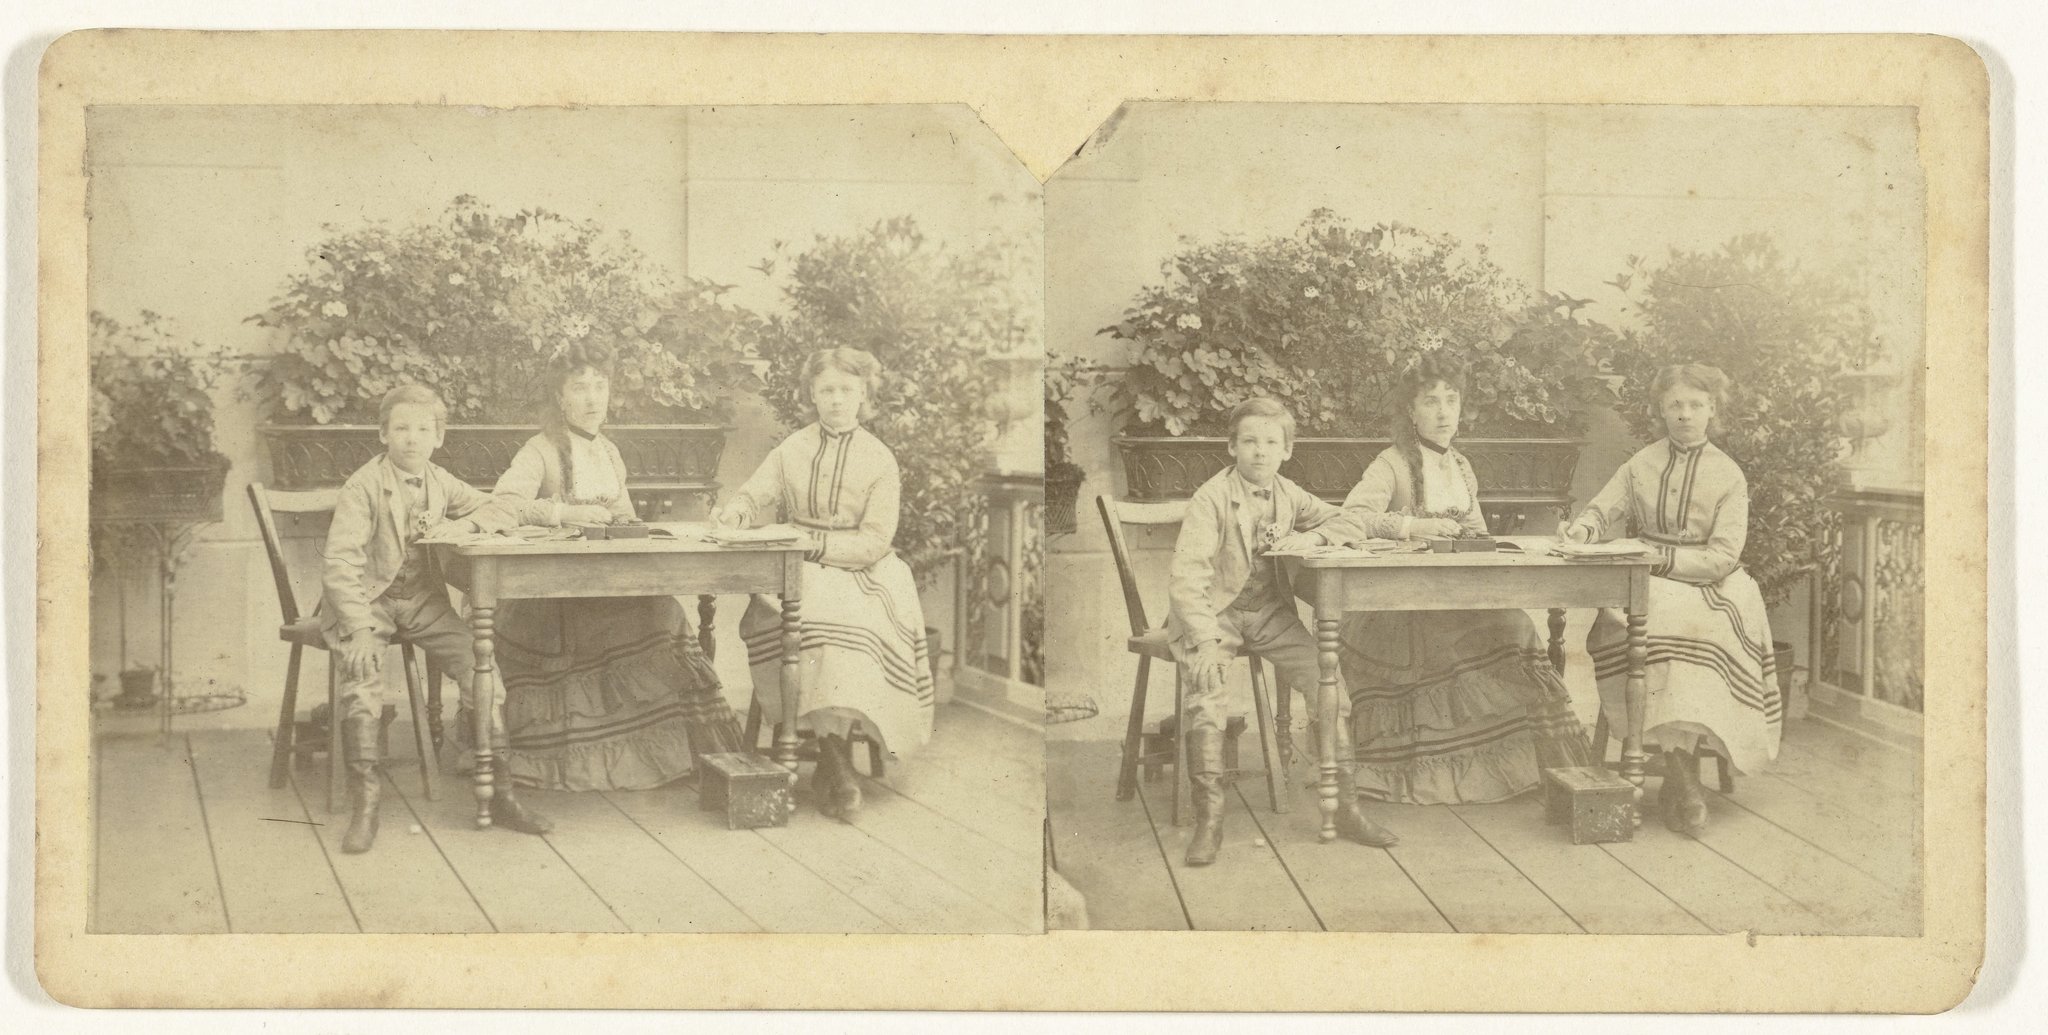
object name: stereograph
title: Portret van Maarten Iman Pauw van Wieldrecht (links), Agnes Henriëtte Pauw van Wieldrecht (rechts) en juffrouw Badollet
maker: matthieu christiaan hendrik pauw van wieldrecht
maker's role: gezant, kamerheer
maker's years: 1816-1895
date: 1869-1873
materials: cardboard, photographic support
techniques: albumen print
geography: netherlands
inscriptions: annotation: ‘Maarten, Juffr. Badollet en A. Pauw. / Papa phot. +- 1873. [1873 doorgehaald voor] 1869.’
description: Maarten Iman (1860-1913) was een broer van Henry, Agnes Henriëtte (‘An’, 1858-1925) een zus.